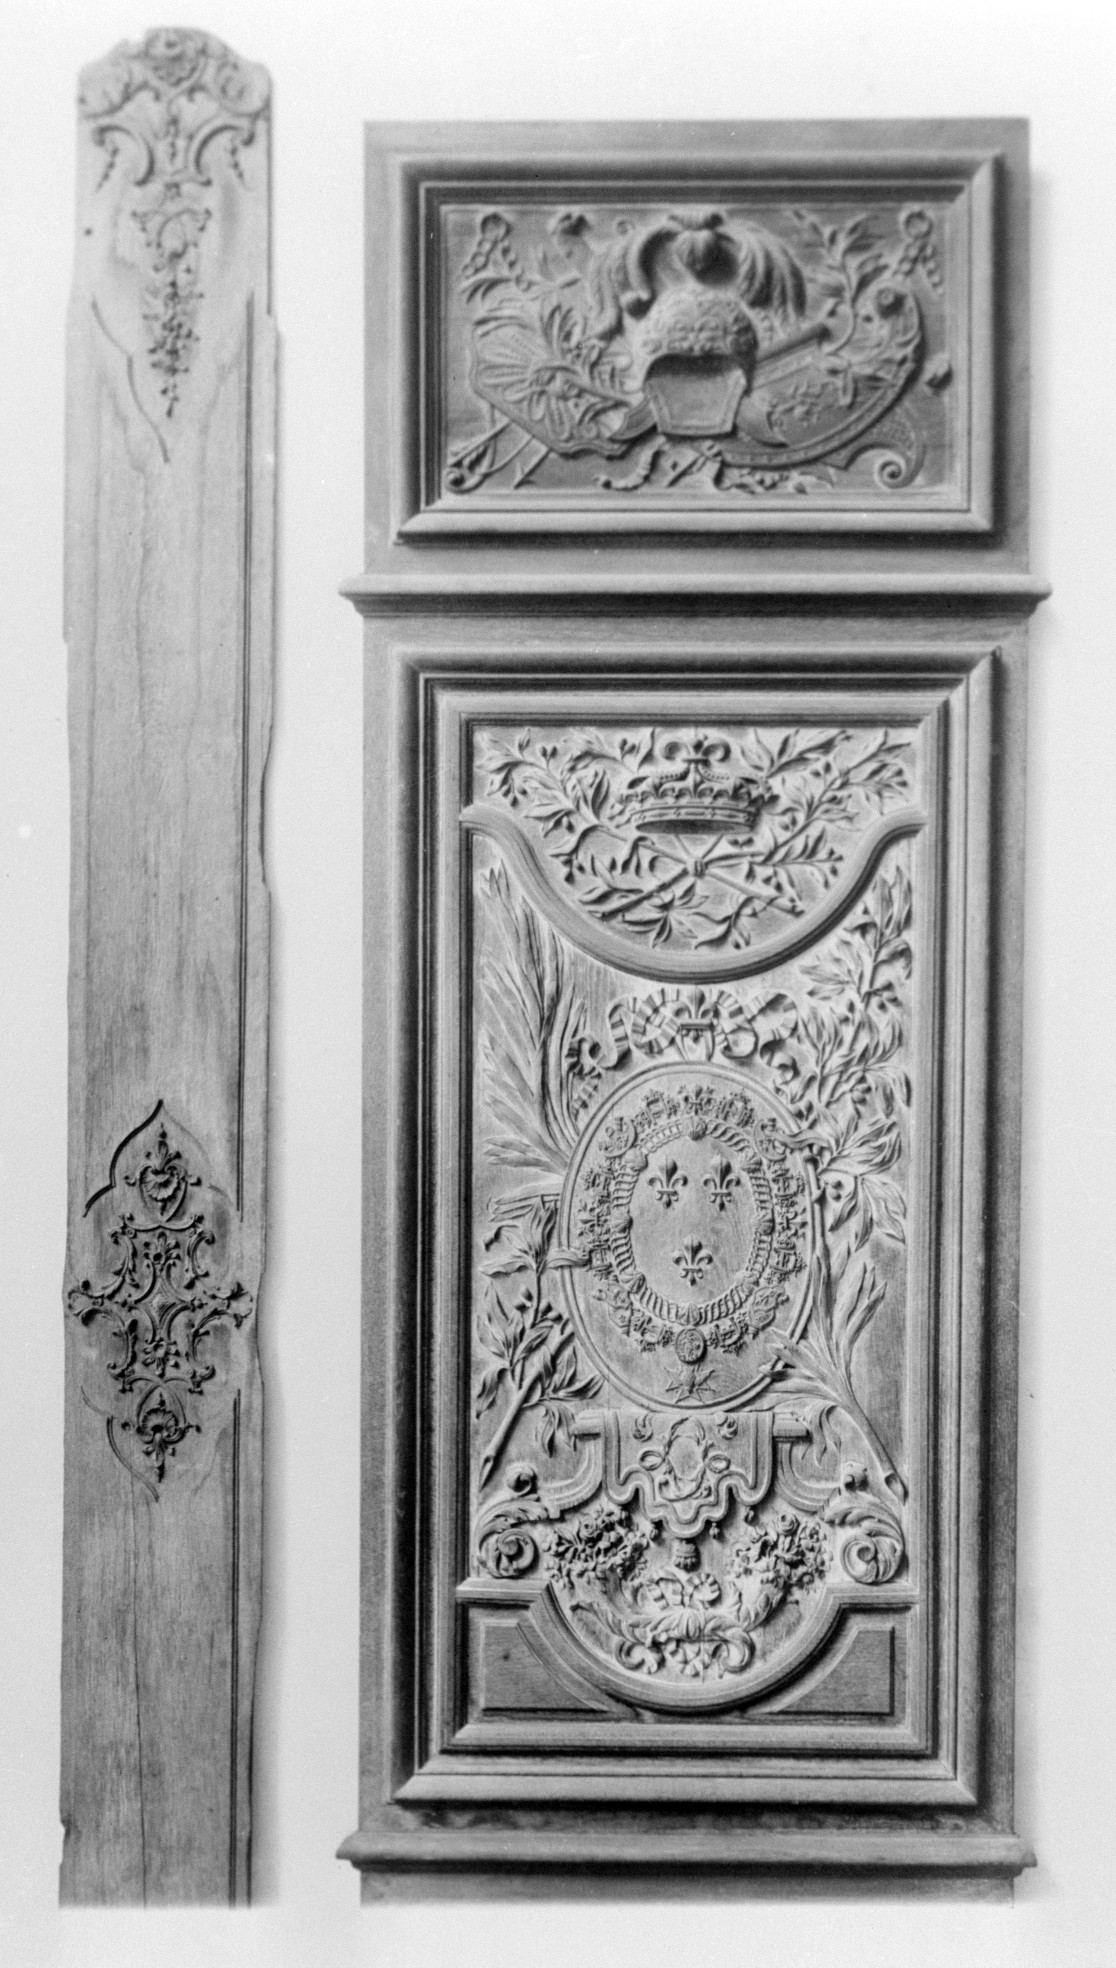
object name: panel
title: Panel (part of a set)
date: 1676-1700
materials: wood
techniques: carving, gilding, painting